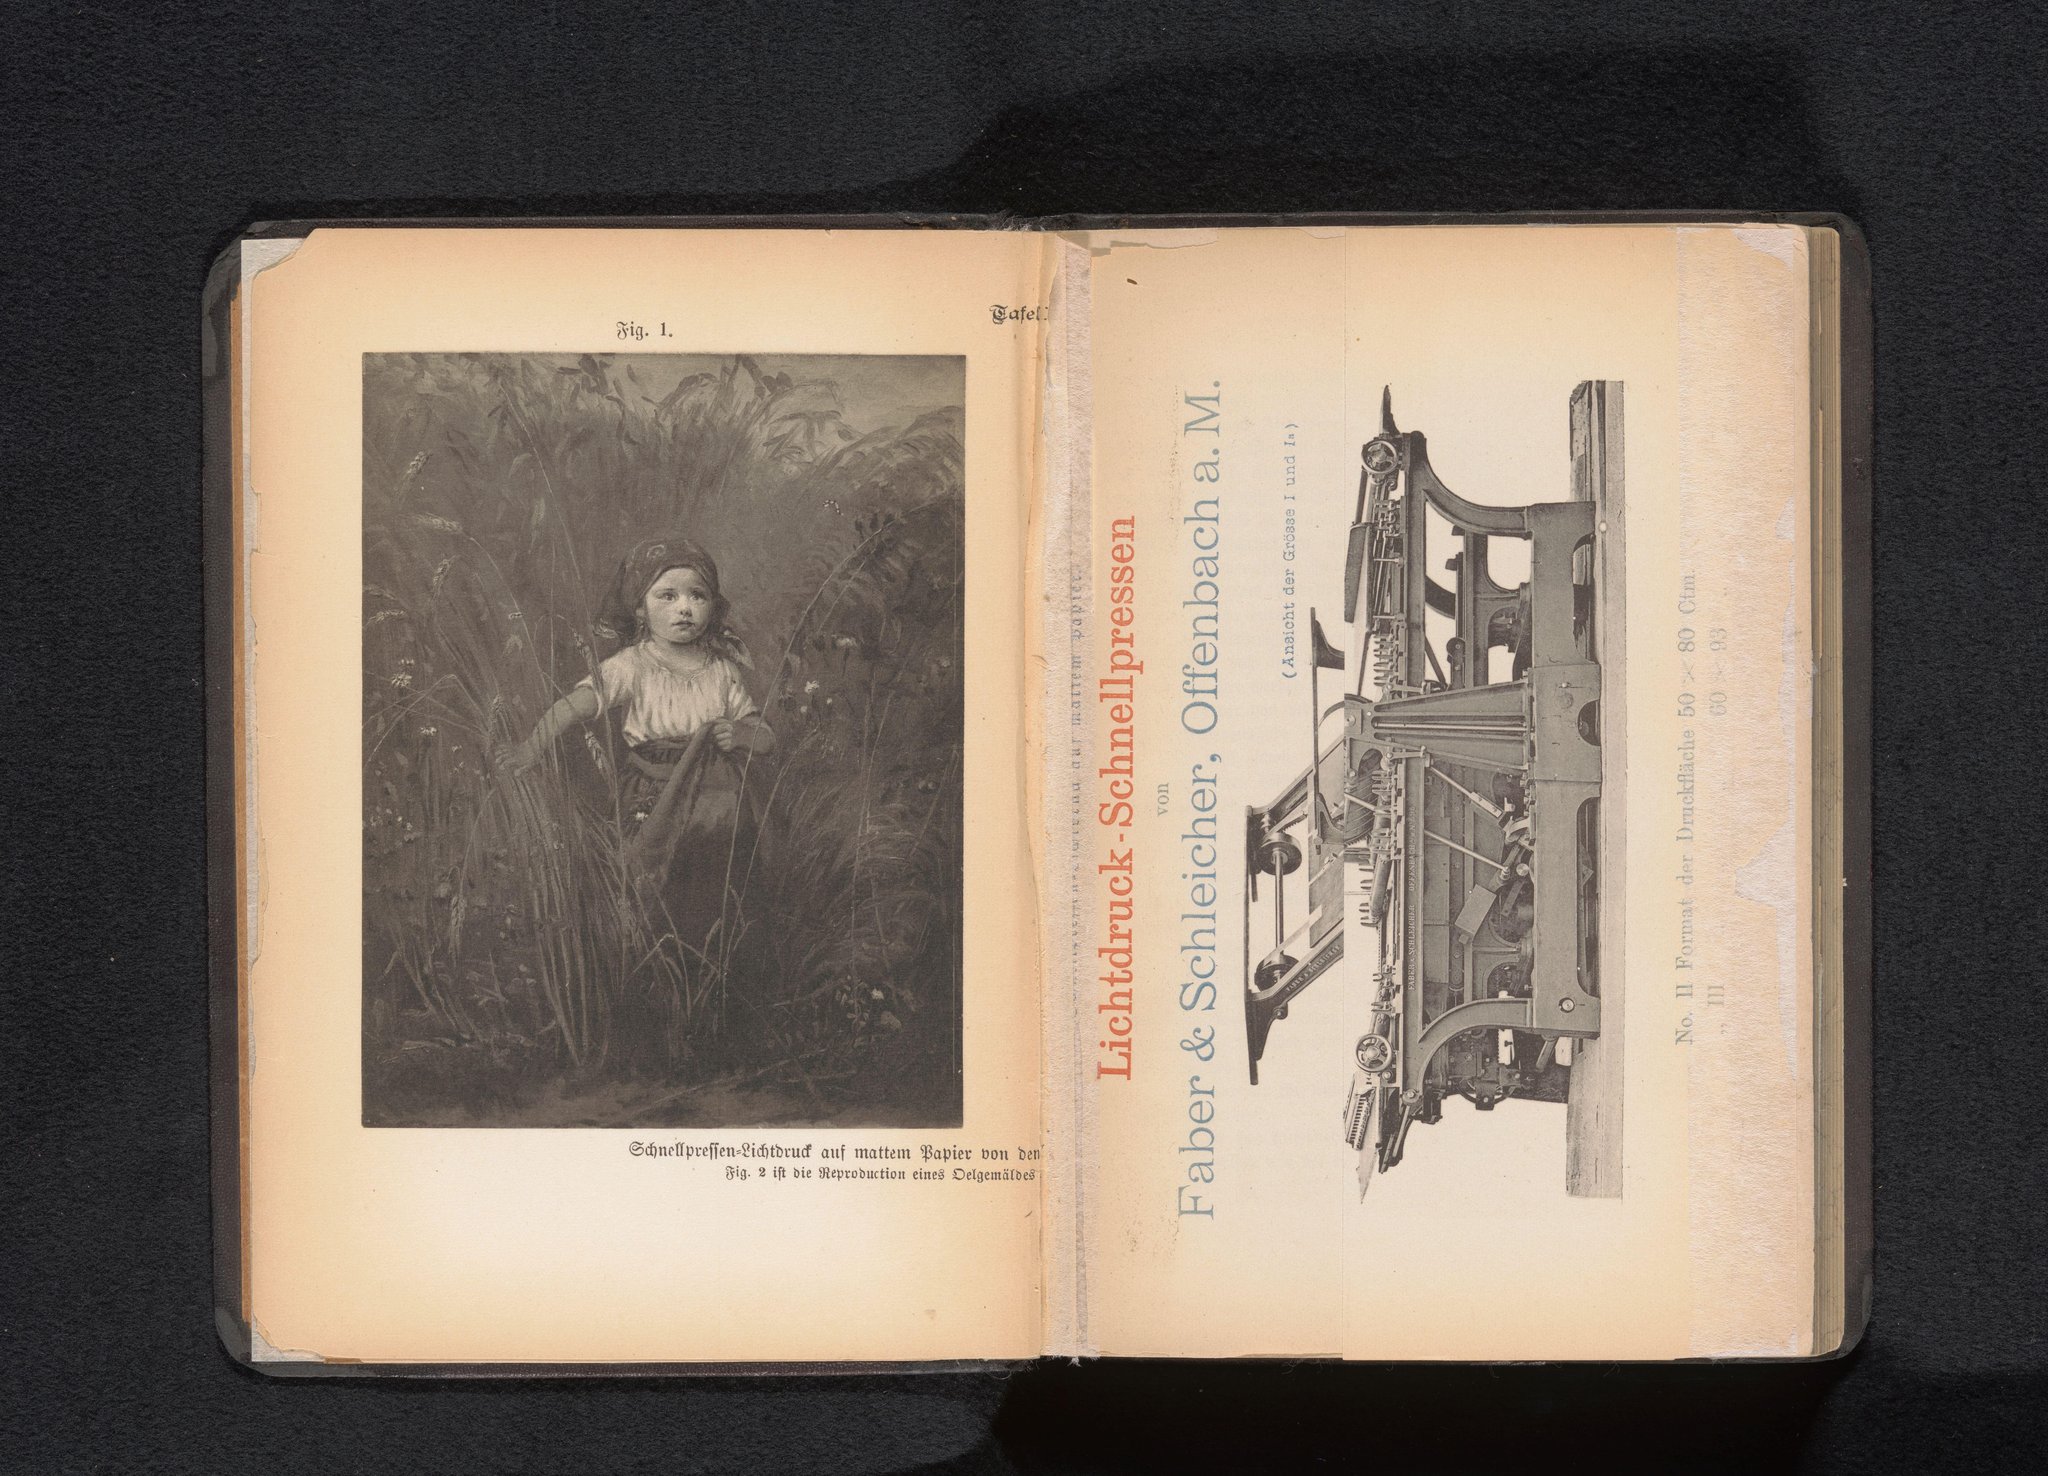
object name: page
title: Fotoreproductie van een schilderij, voorstellende een meisje tussen struikgewas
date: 1875-1885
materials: paper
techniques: photograph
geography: munich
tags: shrubs, girl (child between toddler and youth)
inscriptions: number: ‘Fig. 1.’, inscription: ‘Schnellpressen-lichtdruck auf mattem Papier (...) Delgemäldes’